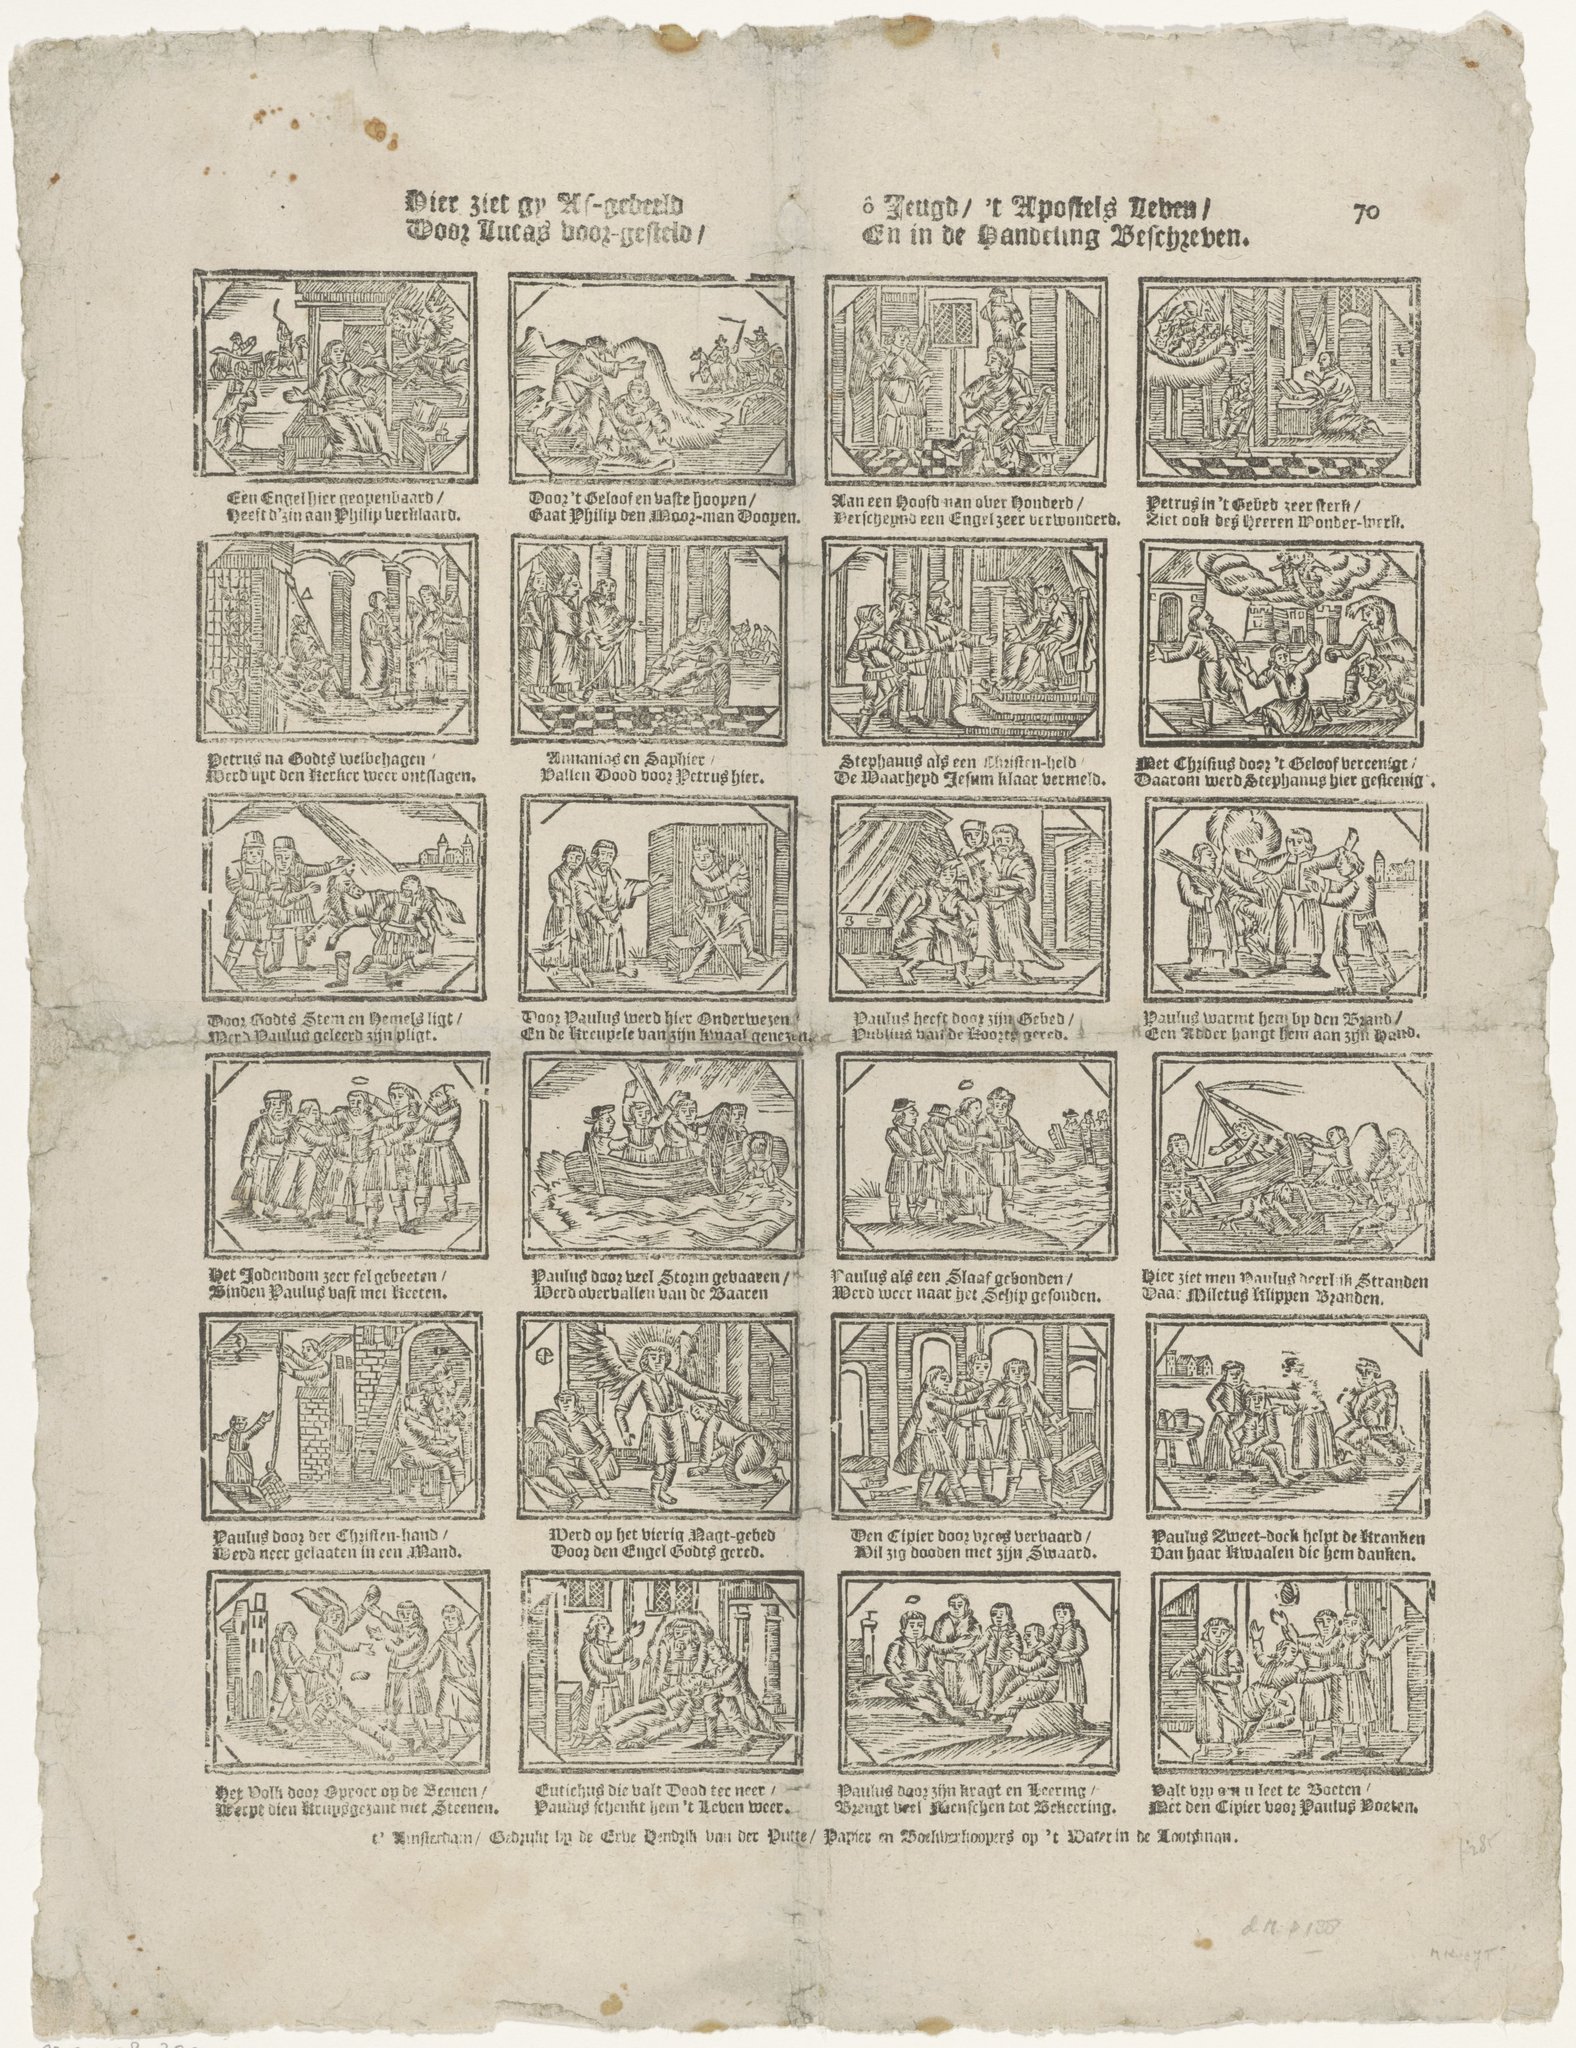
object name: print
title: Hier siet gy af-gebeeld / ô jeugd / 't Apostels leven / Door Lucas voor-gesteld / En in de handeling beschreven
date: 1770-1794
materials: paper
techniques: letterpress printing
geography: amsterdam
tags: lives and acts of the apostles (part ii), lives and acts of the apostles (part i)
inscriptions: collector's mark: Lugt 2228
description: Blad met 24 voorstellingen van de handelingen der apostelen. Onder elke afbeelding een tweeregelig vers. Genummerd rechtsboven: 70.